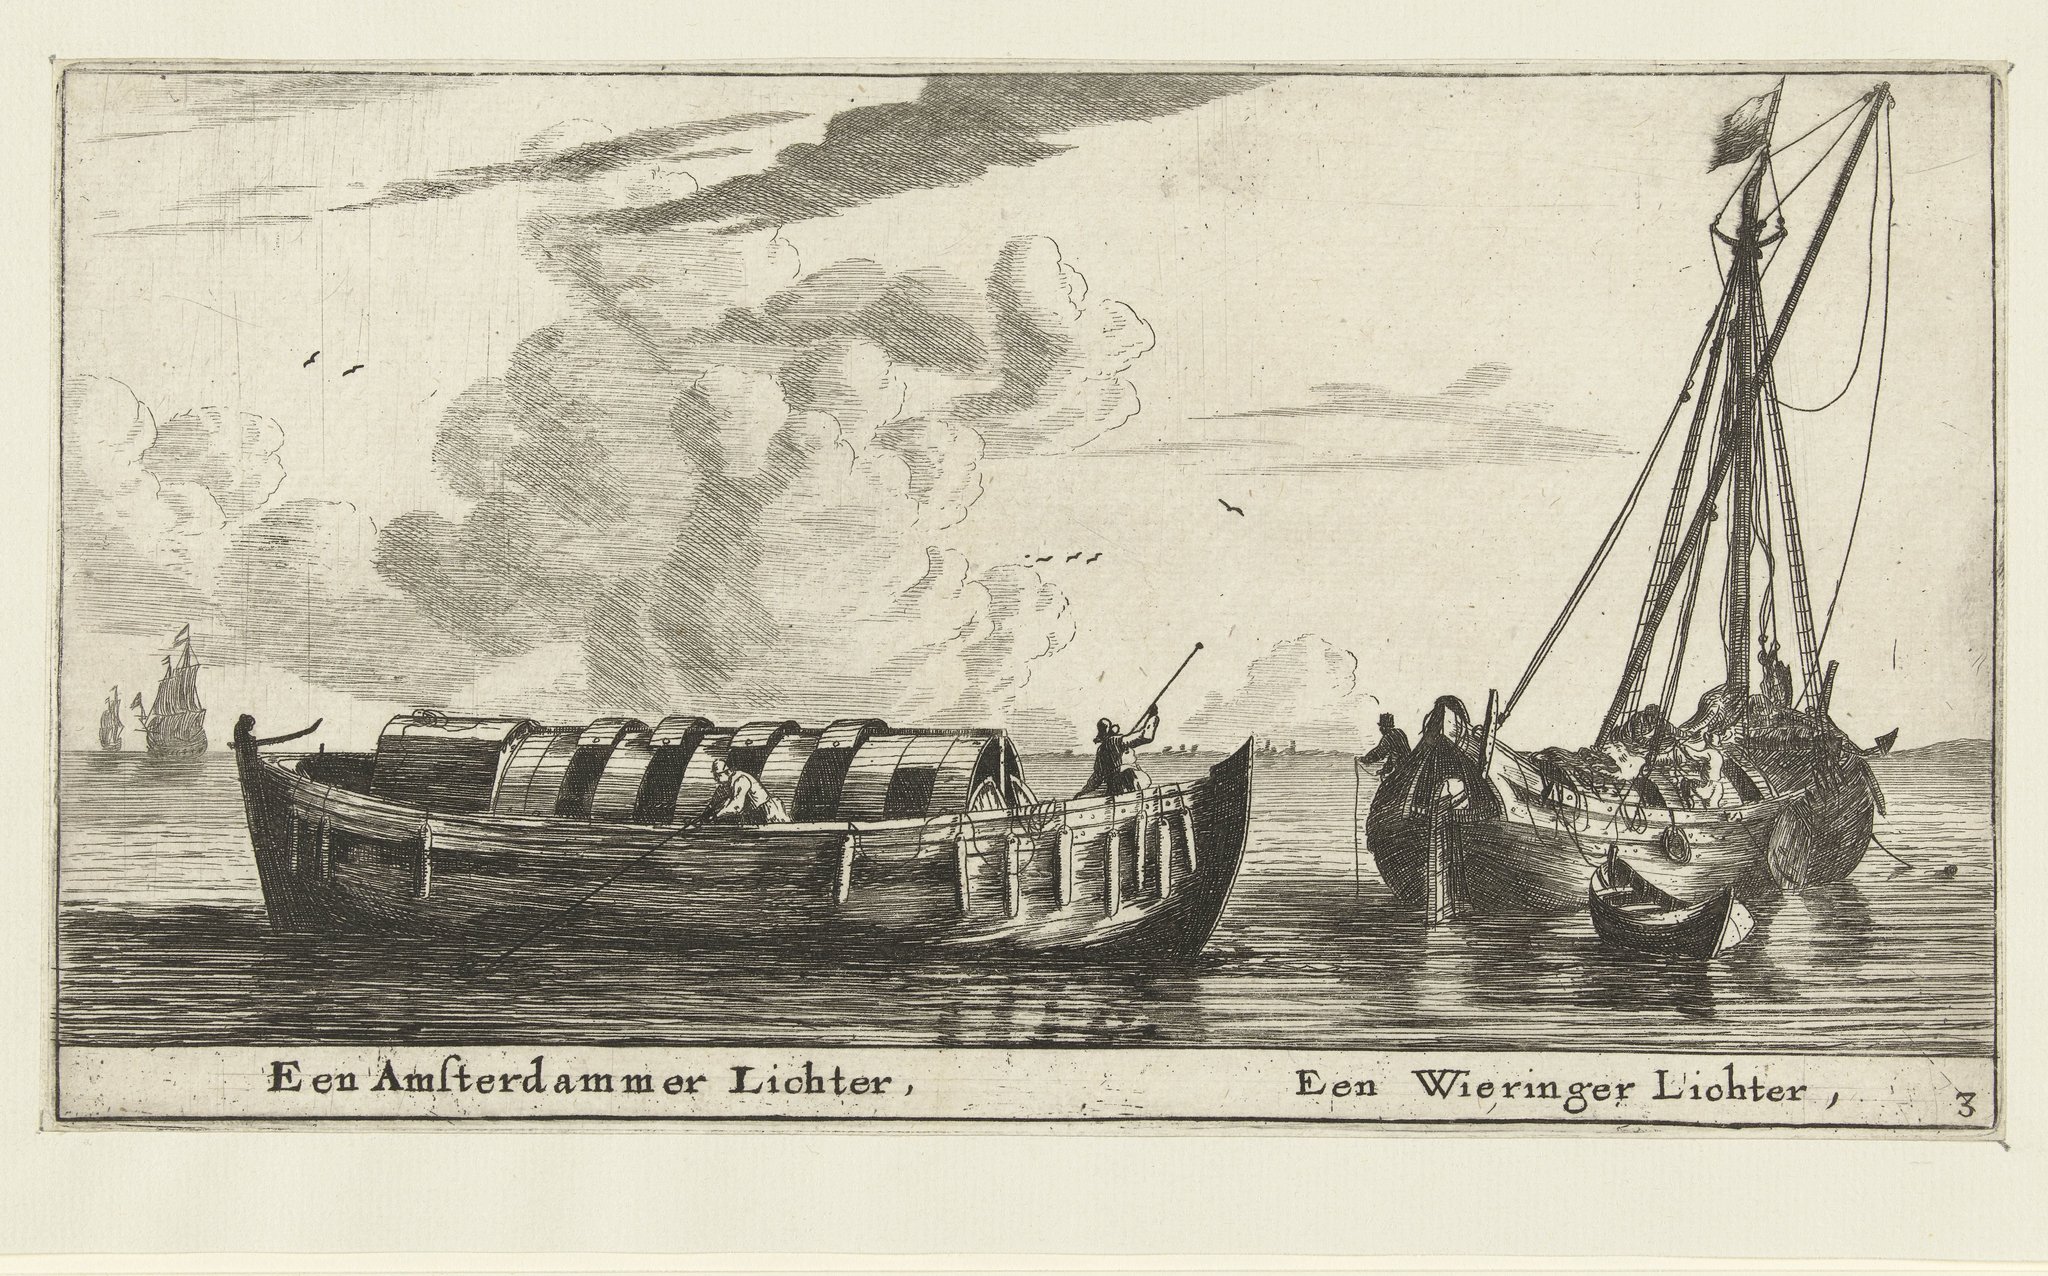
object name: print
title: Verschillende schepen en stadsgezichten van Amsterdam, derde deel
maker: reinier nooms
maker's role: draughtsman, painter, print maker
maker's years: 1623-1664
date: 1652-1654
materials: paper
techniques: drypoint, etching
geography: netherlands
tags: sailing-ship, sailing-boat (with name)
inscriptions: collector's mark: Lugt 12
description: Een Amsterdammer lichter, een klein schip waar de goederen uit een groot schip in kunnen worden overgeladen, en een Wieringer lichter met masten.